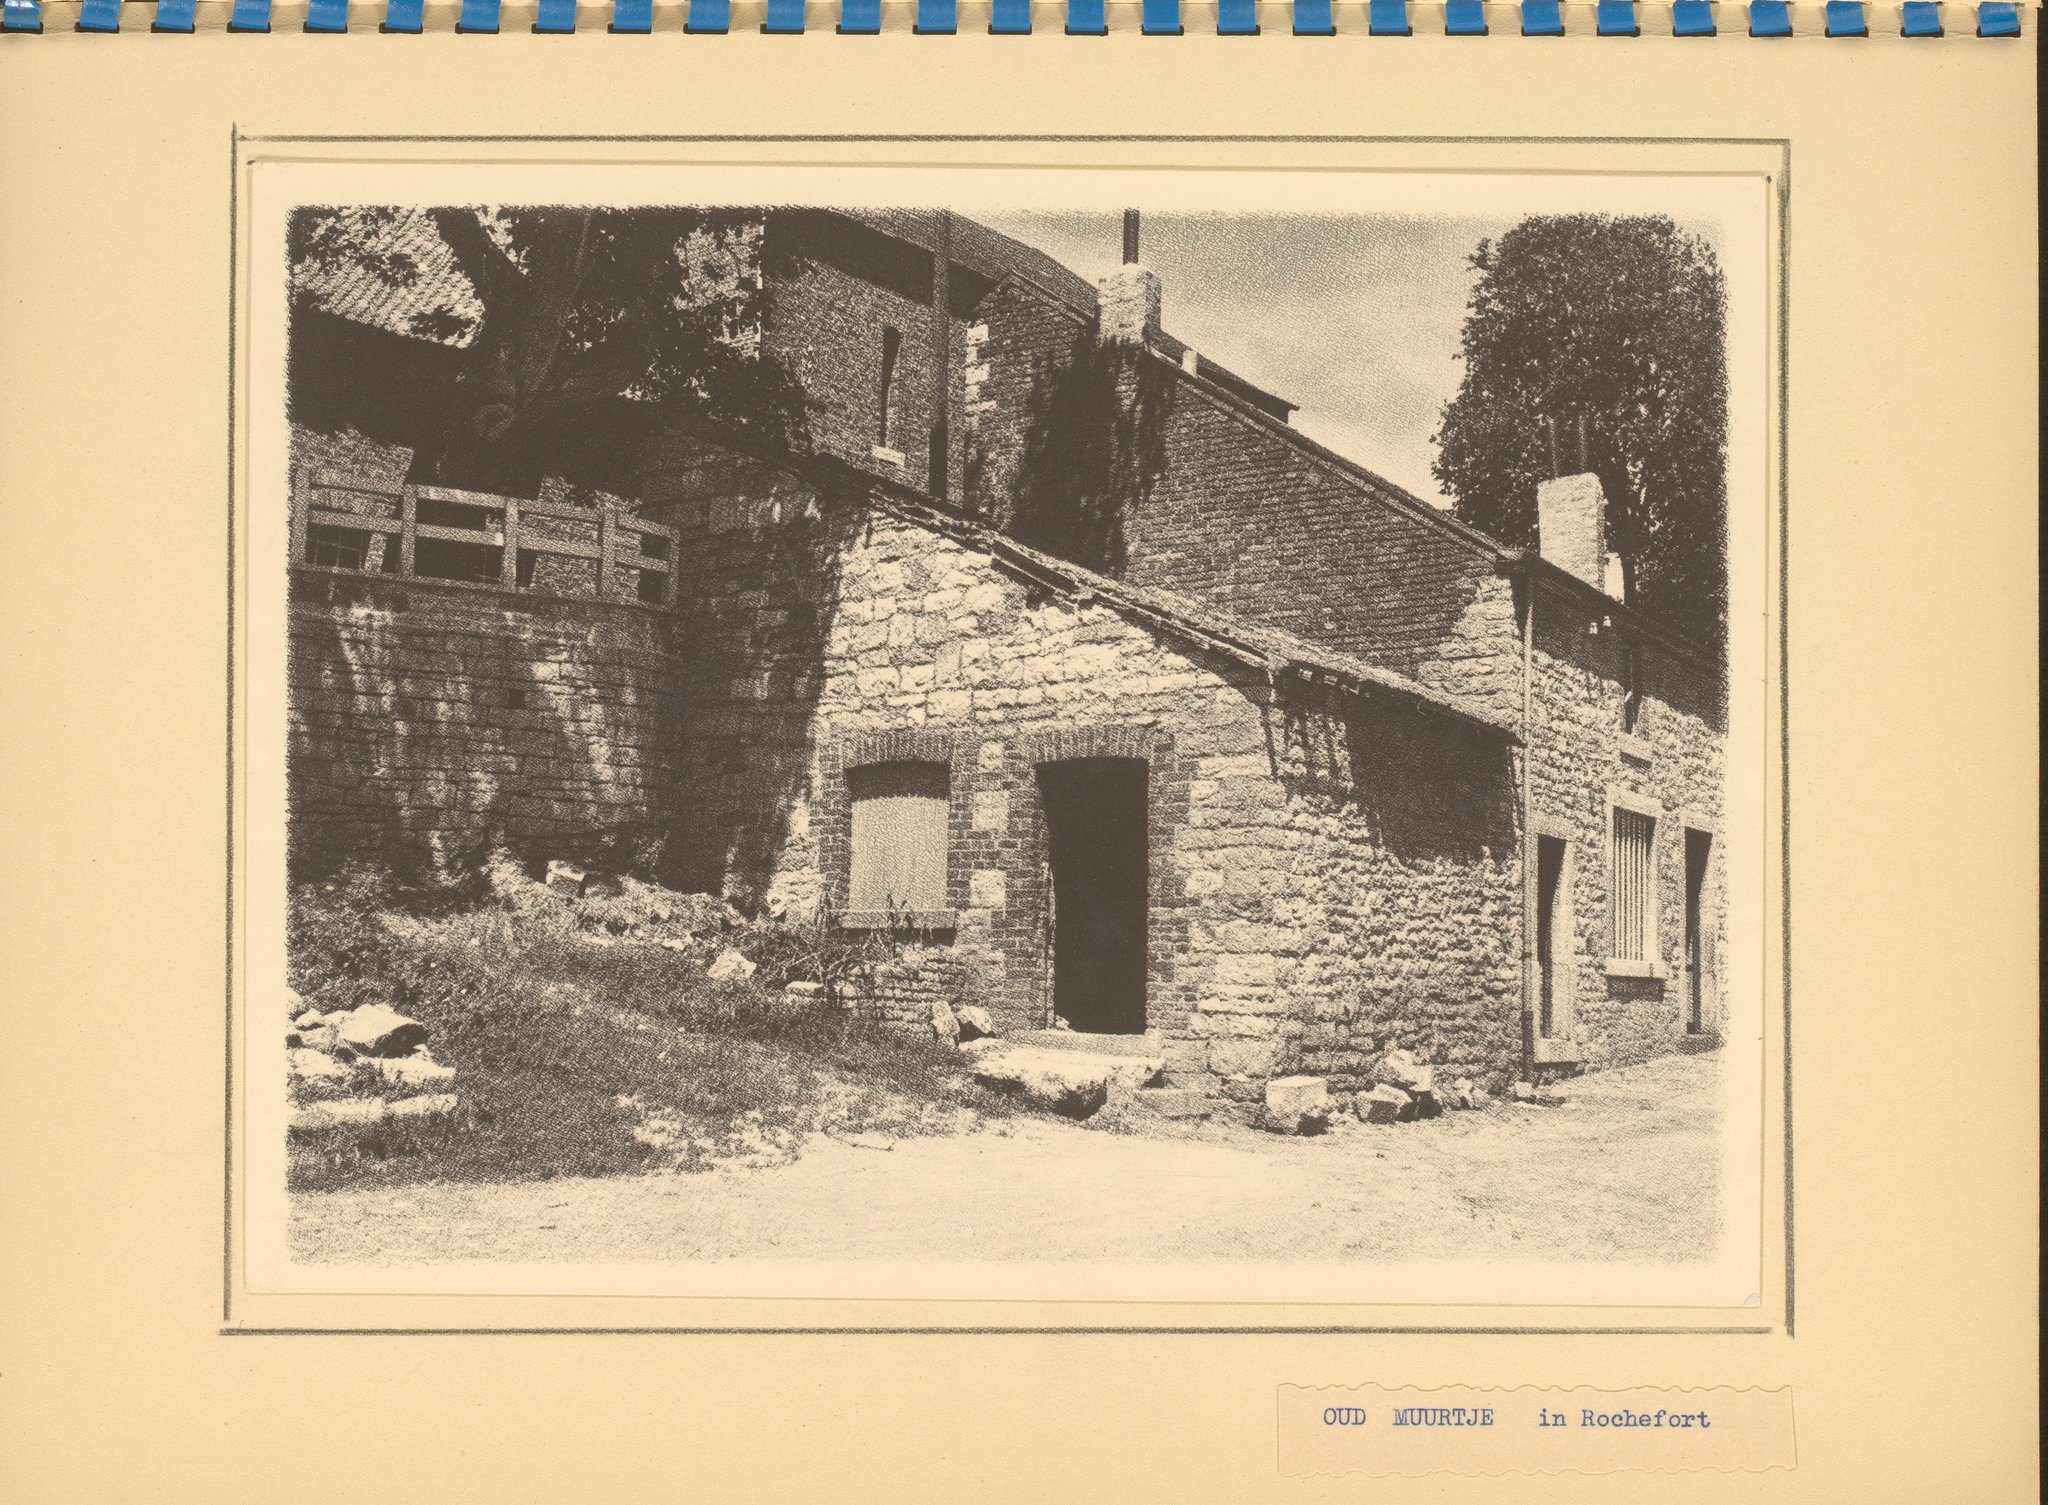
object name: photograph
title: Oud muurtje in Rochefort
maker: gerrit elink schuurman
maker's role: fotograaf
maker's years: 1876-1953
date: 1935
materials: paper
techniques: gelatin silver print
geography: rochefort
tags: housing